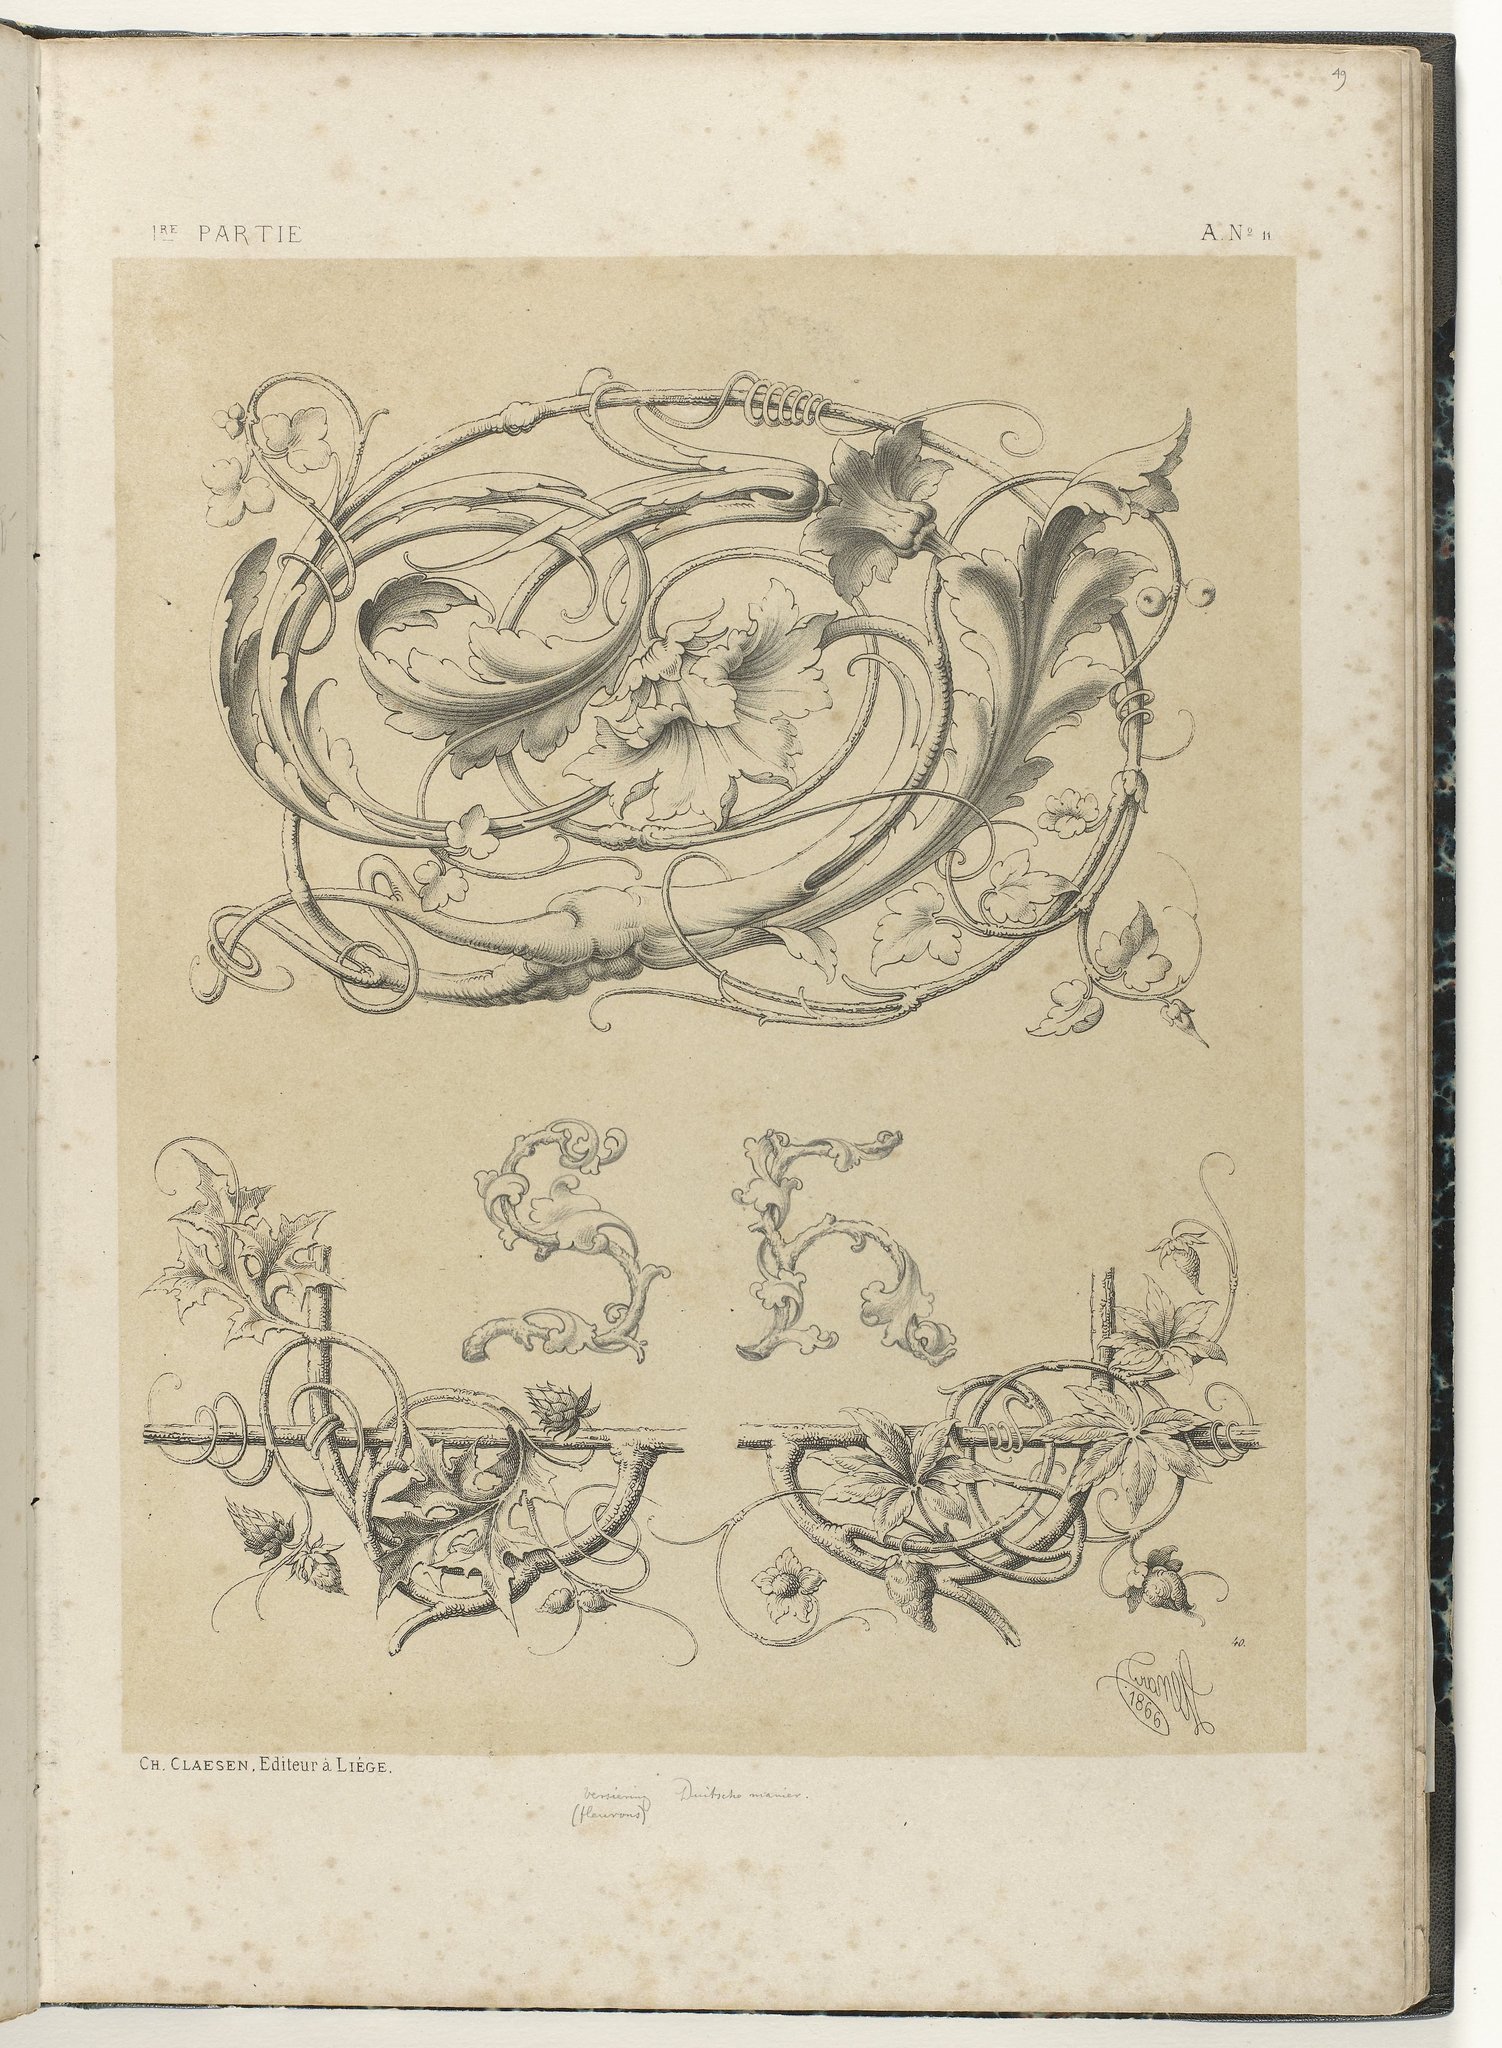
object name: print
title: Vijf ornamenten van takken met bladeren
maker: michel liénard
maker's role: print maker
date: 1866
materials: paper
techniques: tone lithography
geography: liège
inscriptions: annotation: ‘Versiering Duitsche manier. (fleurons)’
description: Bovenaan staat een opgekrulde bladrank afgebeeld, in het midden twee letters van takken met bladeren en onderaan twee hoeken van lijsten opgebouwd uit takken. Linksboven: 1re partie, rechtsboven: A. N° 11, rechtsonder: 40.